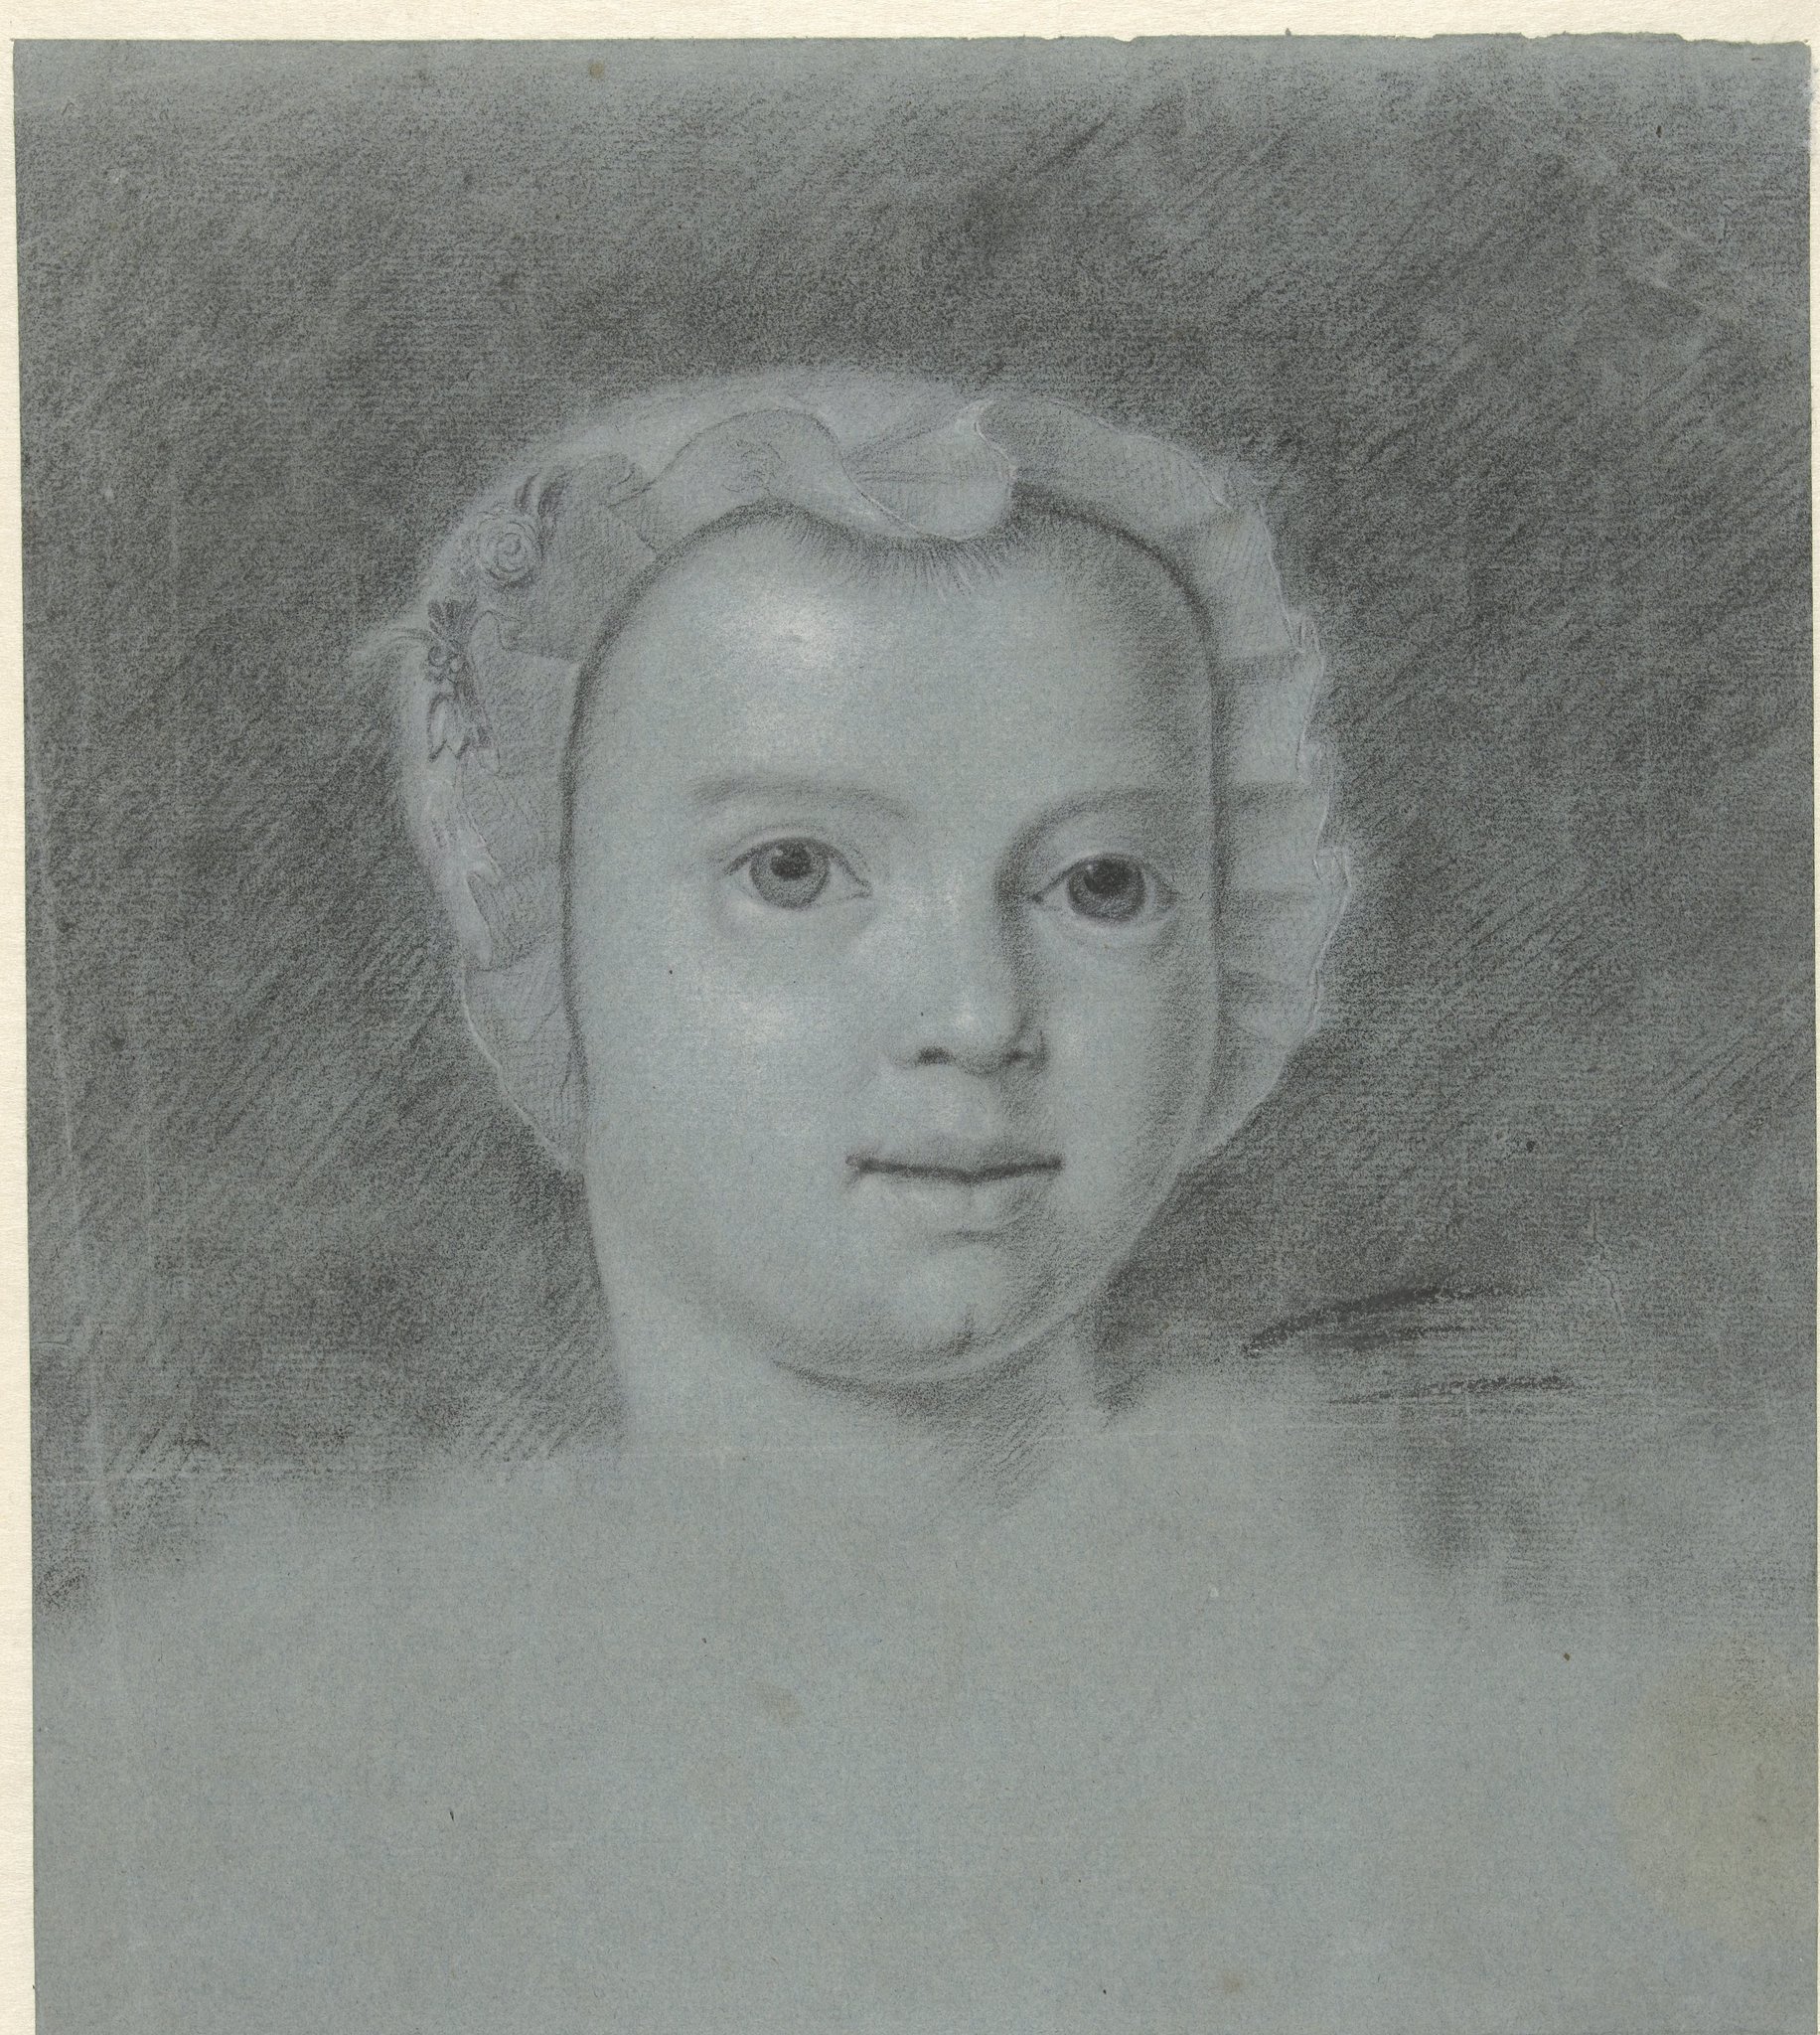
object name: drawing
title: Hoofd van een meisje met wit mutsje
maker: mattheus verheyden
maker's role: draughtsman, painter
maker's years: 1700-1777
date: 1710-1777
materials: chalk, paper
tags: head (human)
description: Afkomstig uit een tekeningenalbum met onder andere figuur- en handstudies van of naar Caspar en Constantijn Netscher (BI-1894-3720). Tekening bevond zich oorspronkelijk op f. 47.